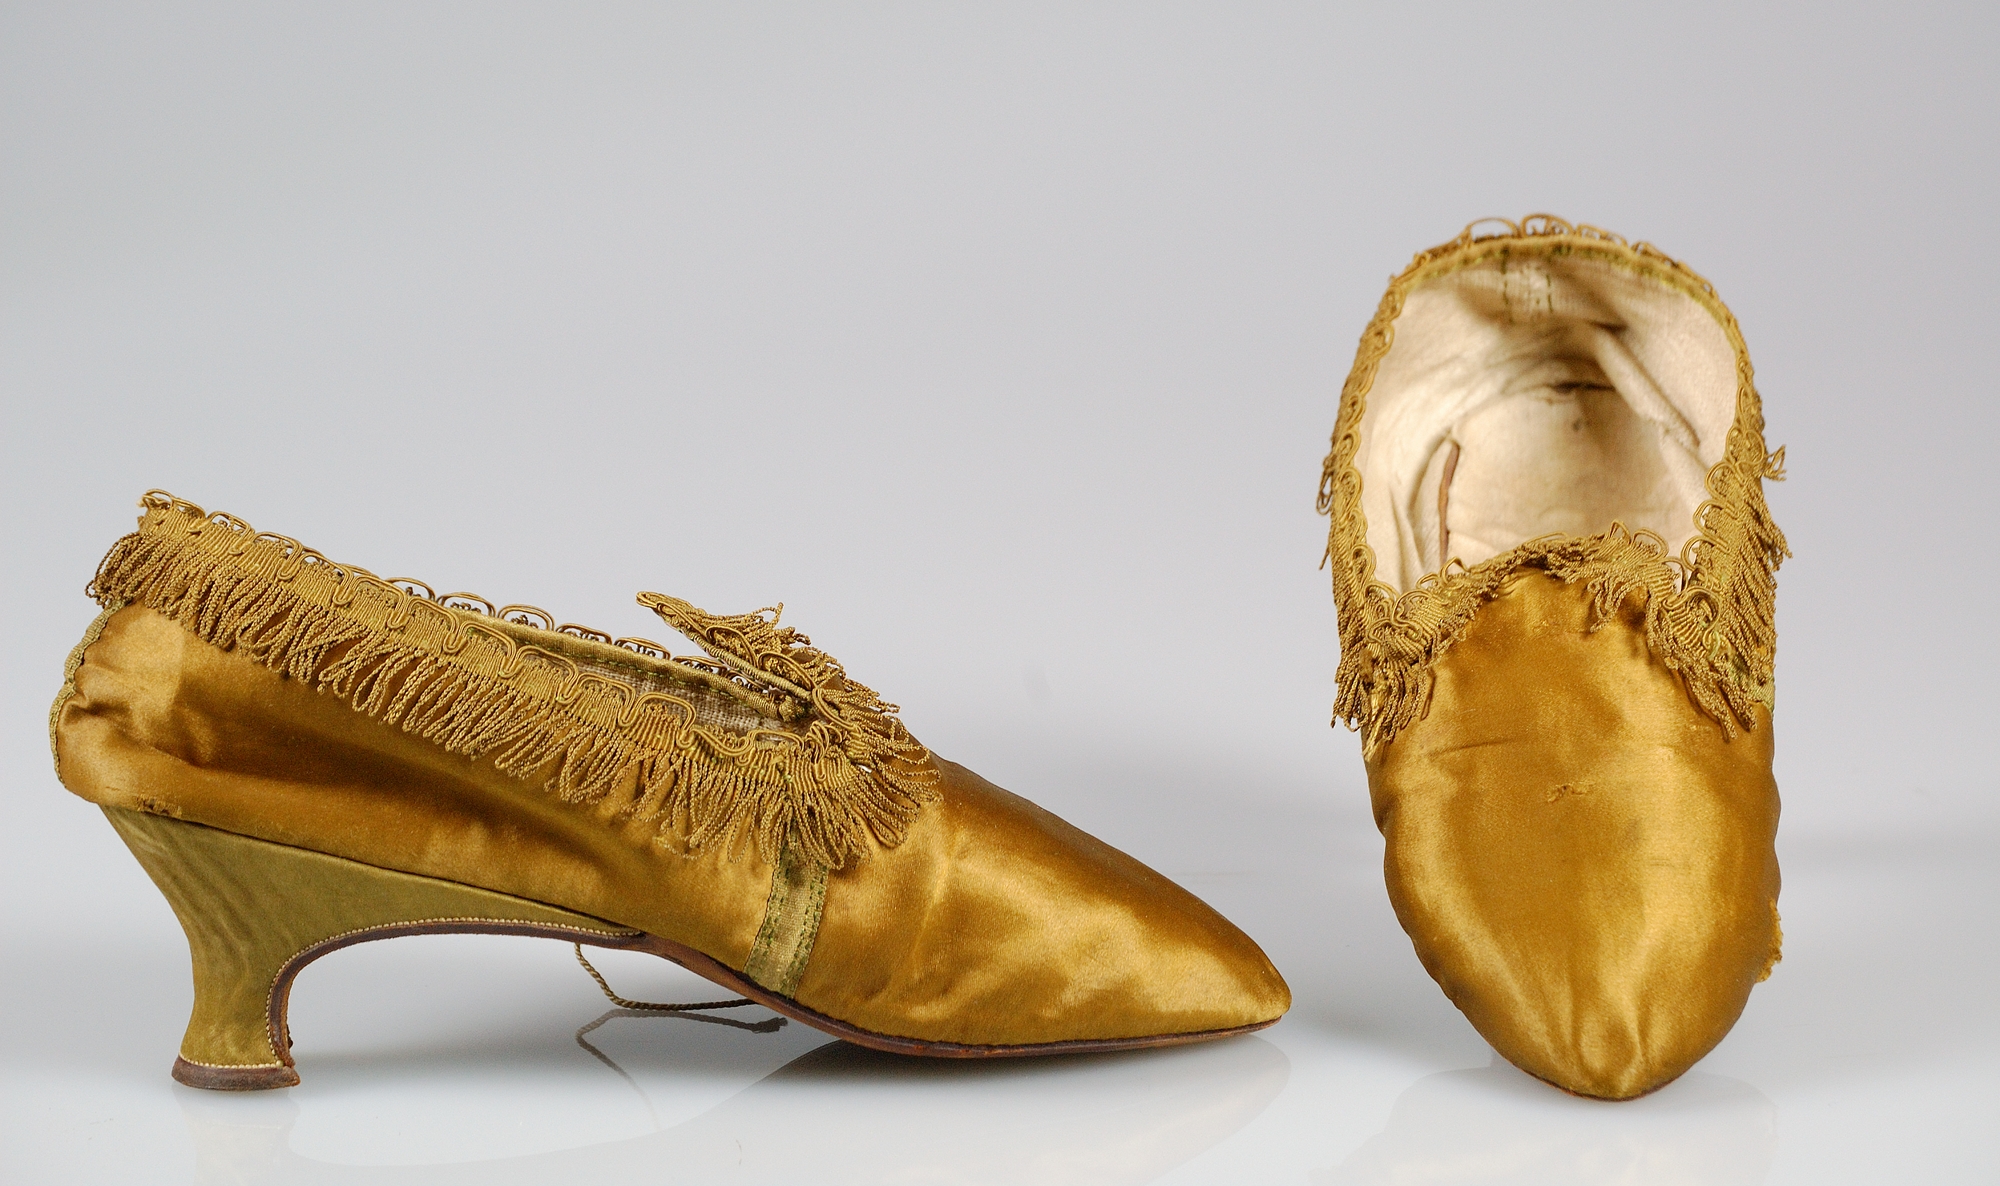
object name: slipper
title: Slippers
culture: european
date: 1780-1789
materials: silk